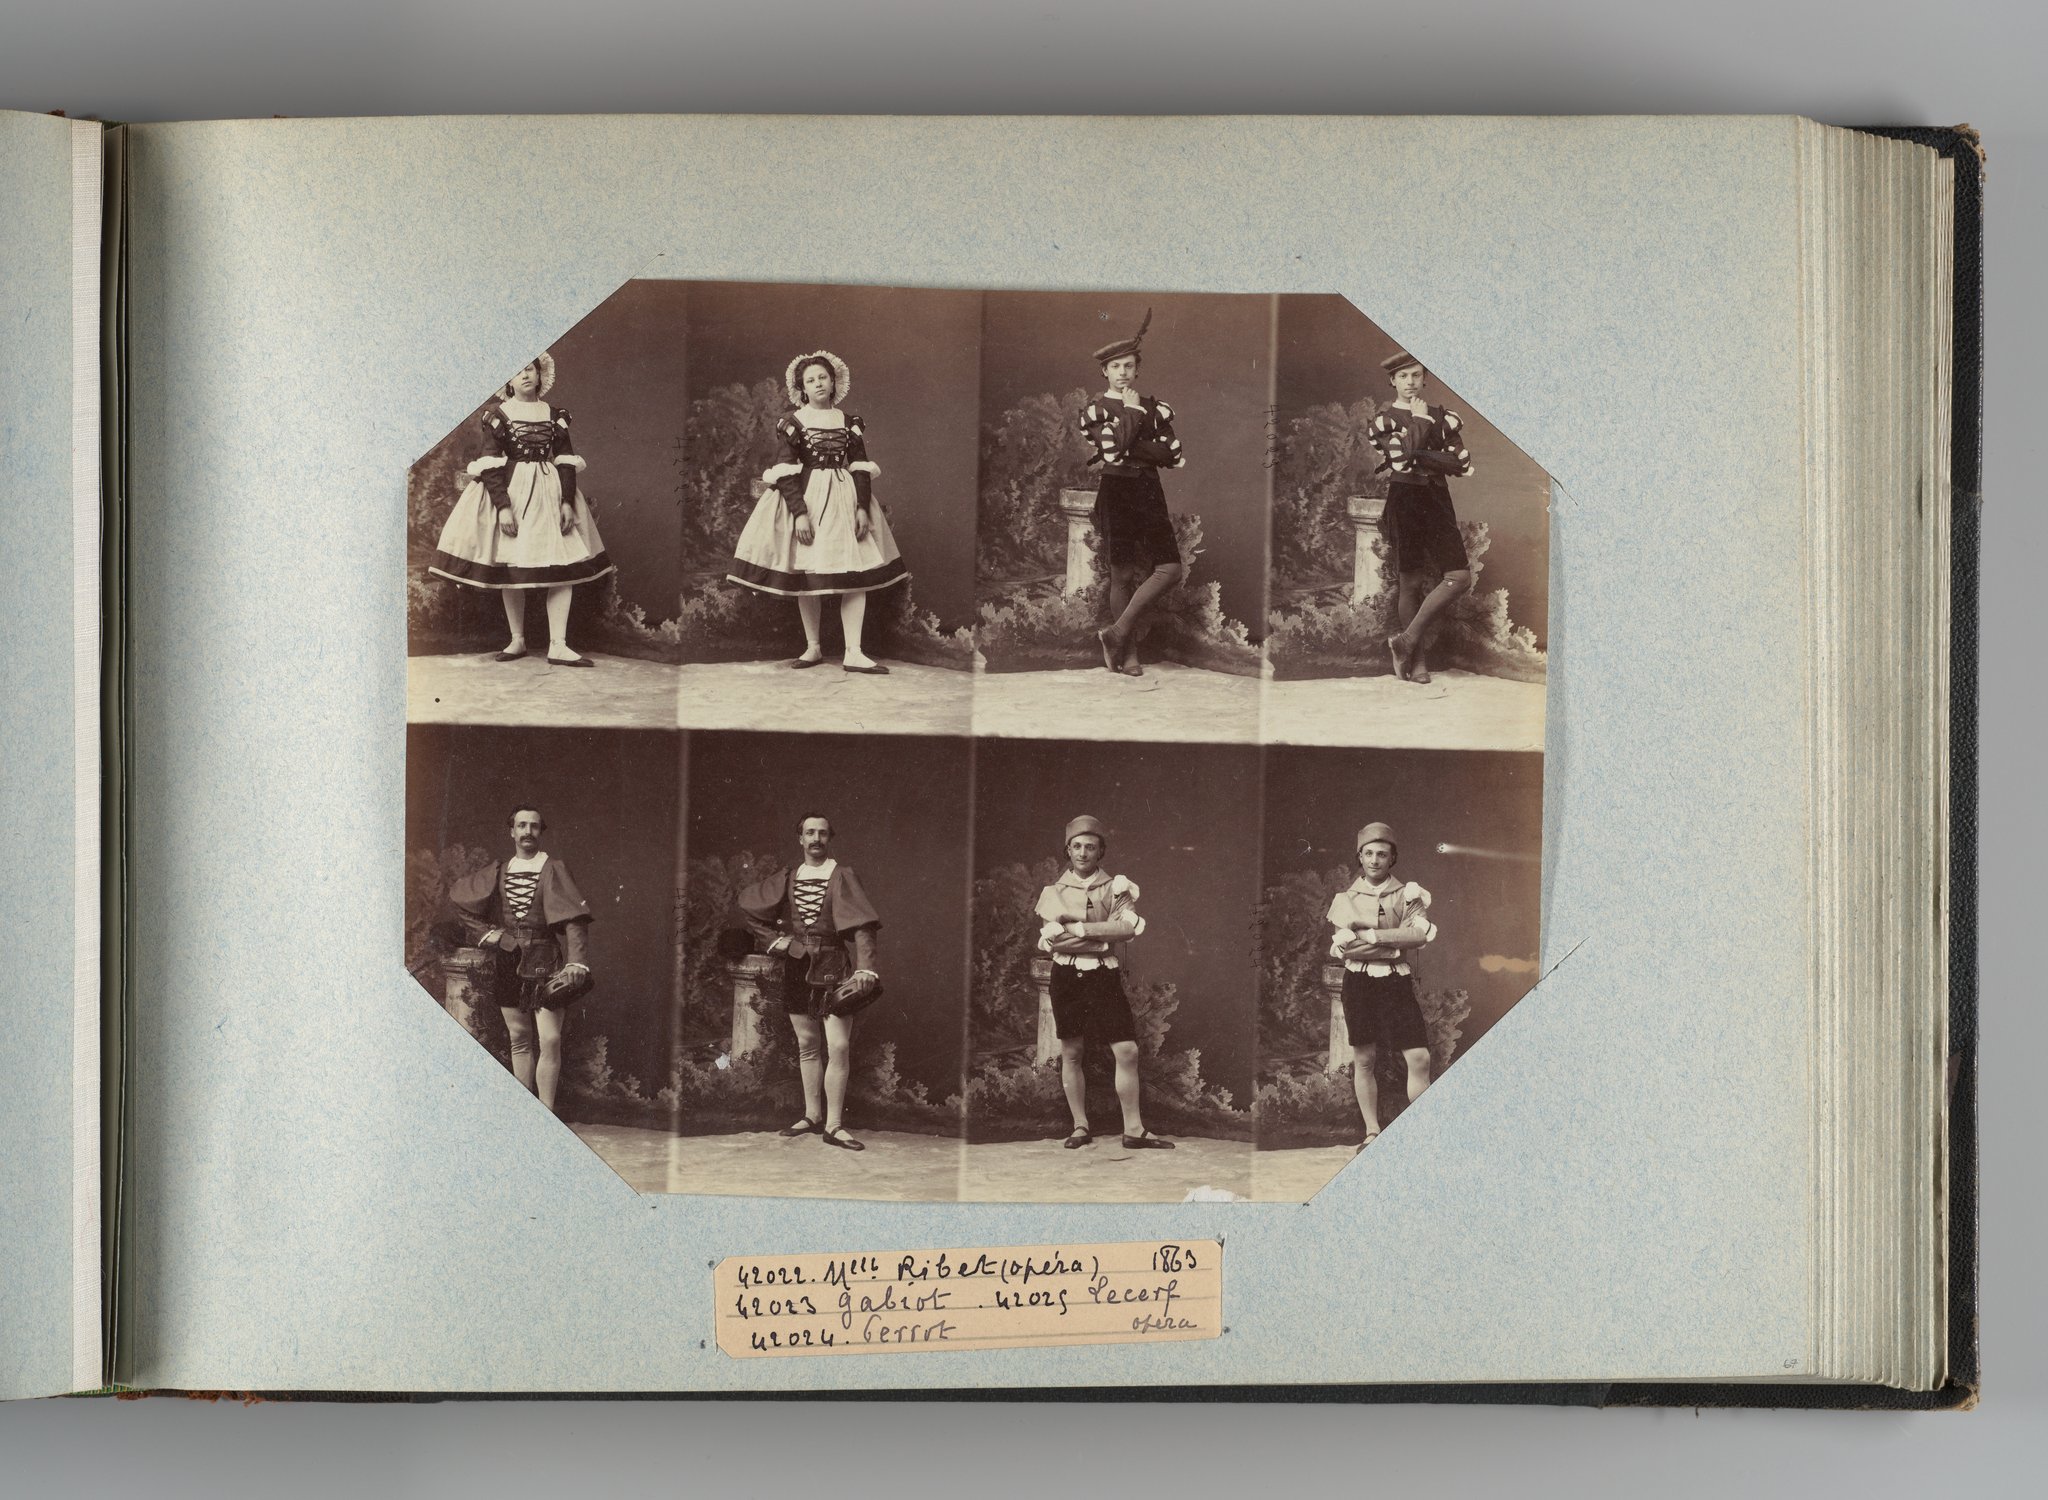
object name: photograph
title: Mlle Ribert; Gabiot; Perrot; Lecerf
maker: andré-adolphe-eugène disdéri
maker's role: artist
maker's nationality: french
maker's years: 1819-1889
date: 1863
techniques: albumen silver print, glass negative